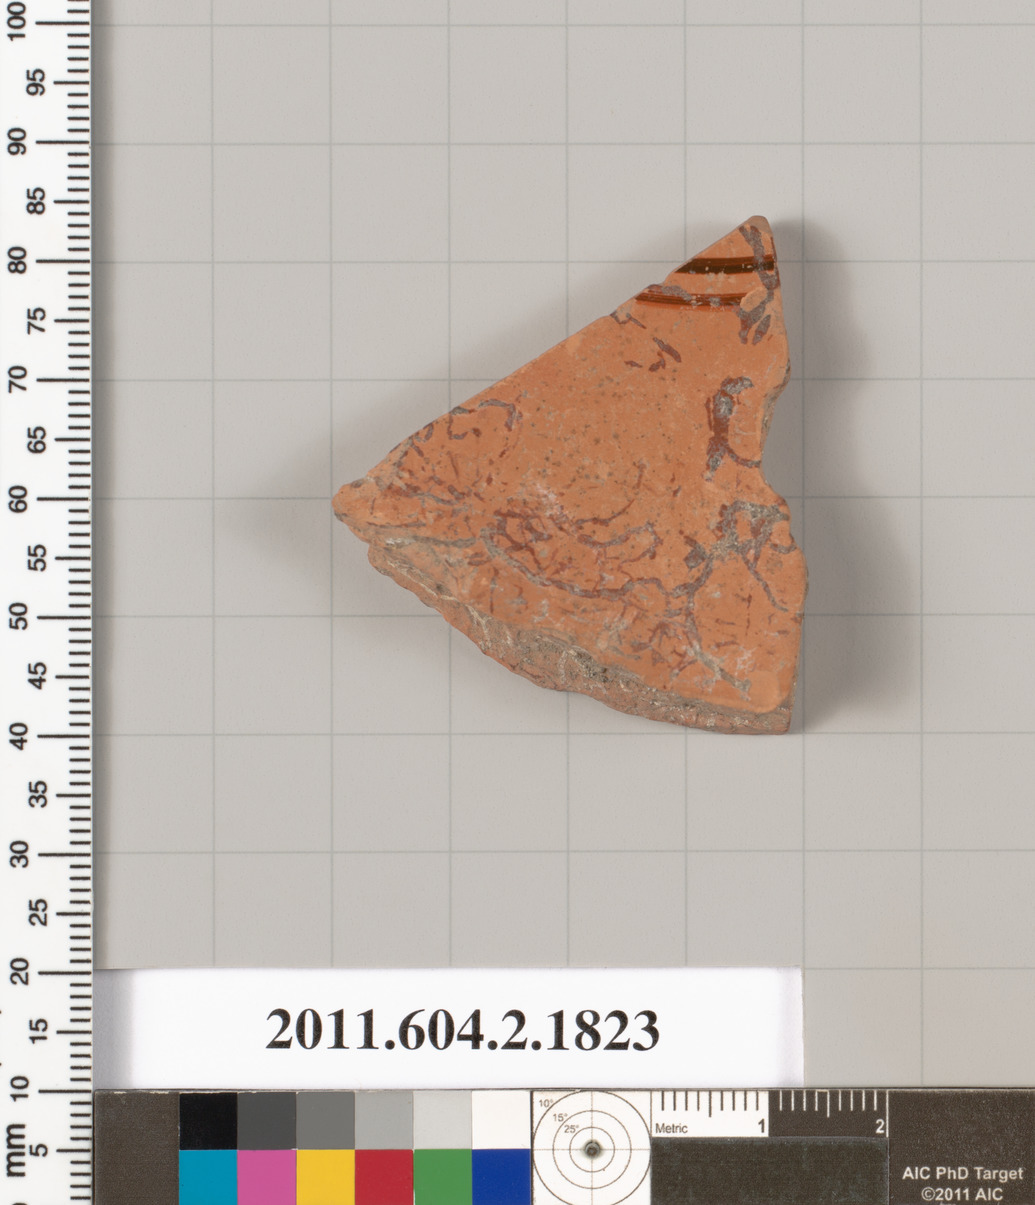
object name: skyphos fragment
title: Terracotta fragment of a skyphos (deep drinking cup)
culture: greek, attic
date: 425-401 BCE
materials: terracotta